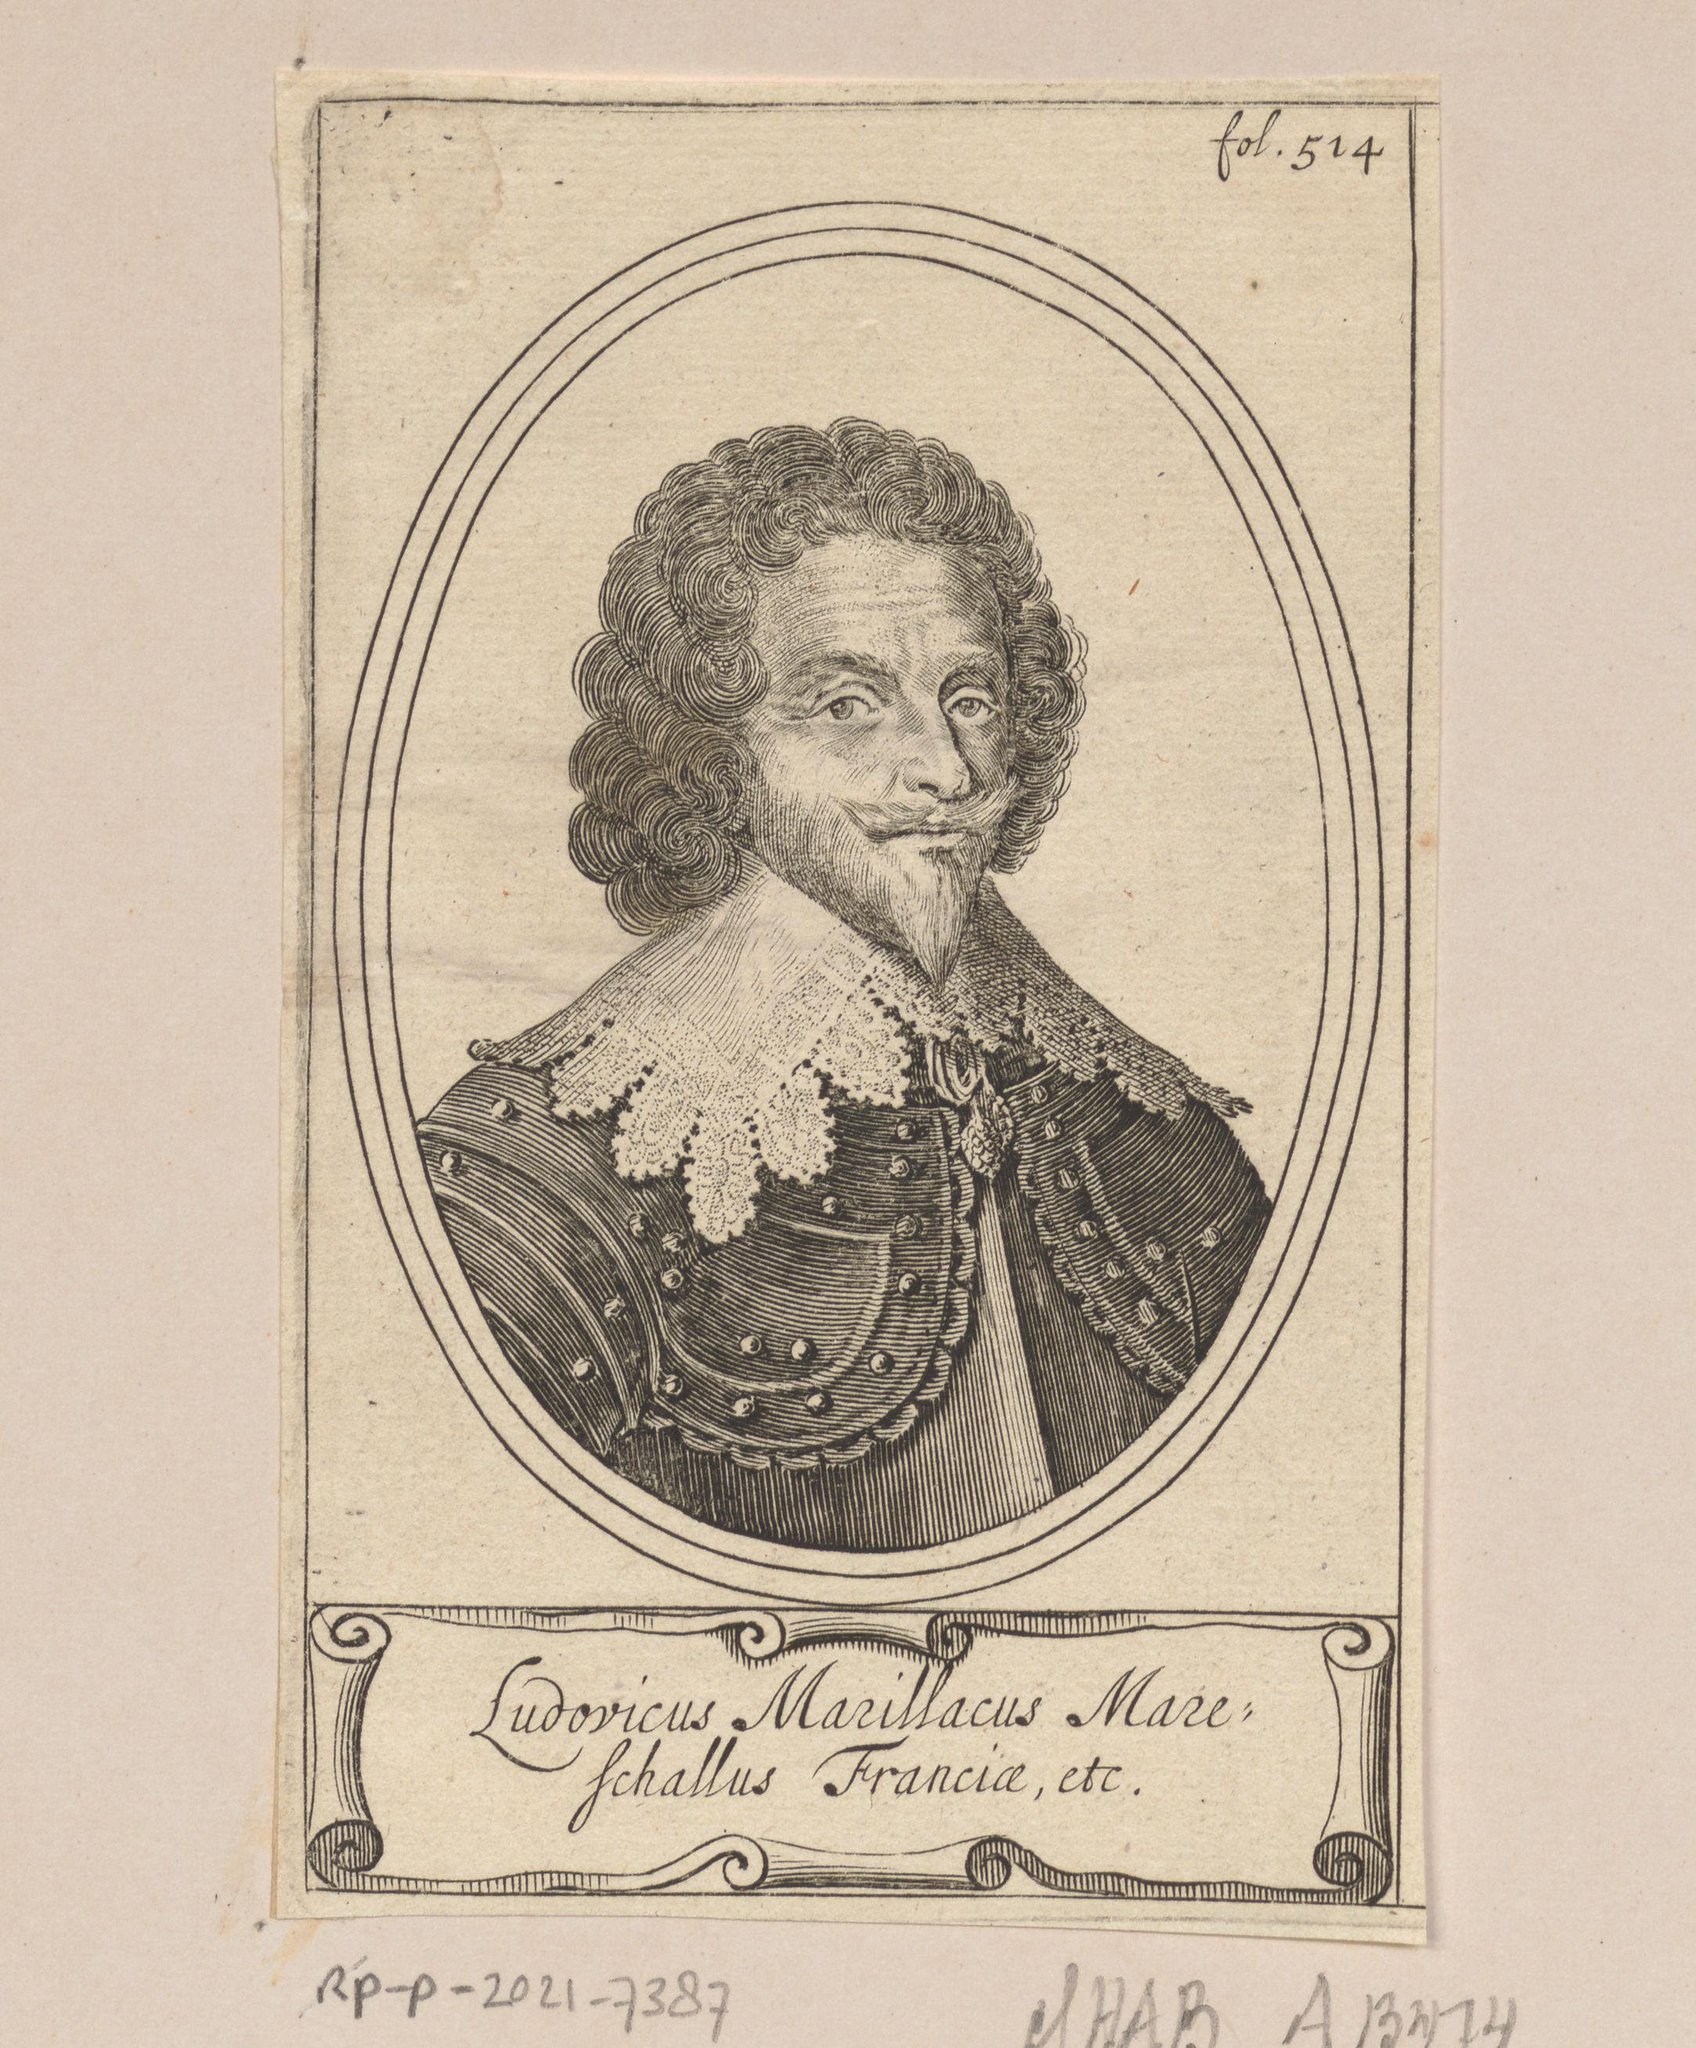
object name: print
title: Portret van Louis de Marillac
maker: Anonymous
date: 1650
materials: paper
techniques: engraving, etching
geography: northern netherlands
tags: paris, historical persons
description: Eerdere staat gebruikt in: Bos, Lambert van den. Het treur-toonneel der doorluchtige mannen onser eeuwe (...). Amsterdam: Nicolaes van Ravesteyn, 1650, dl. 1.